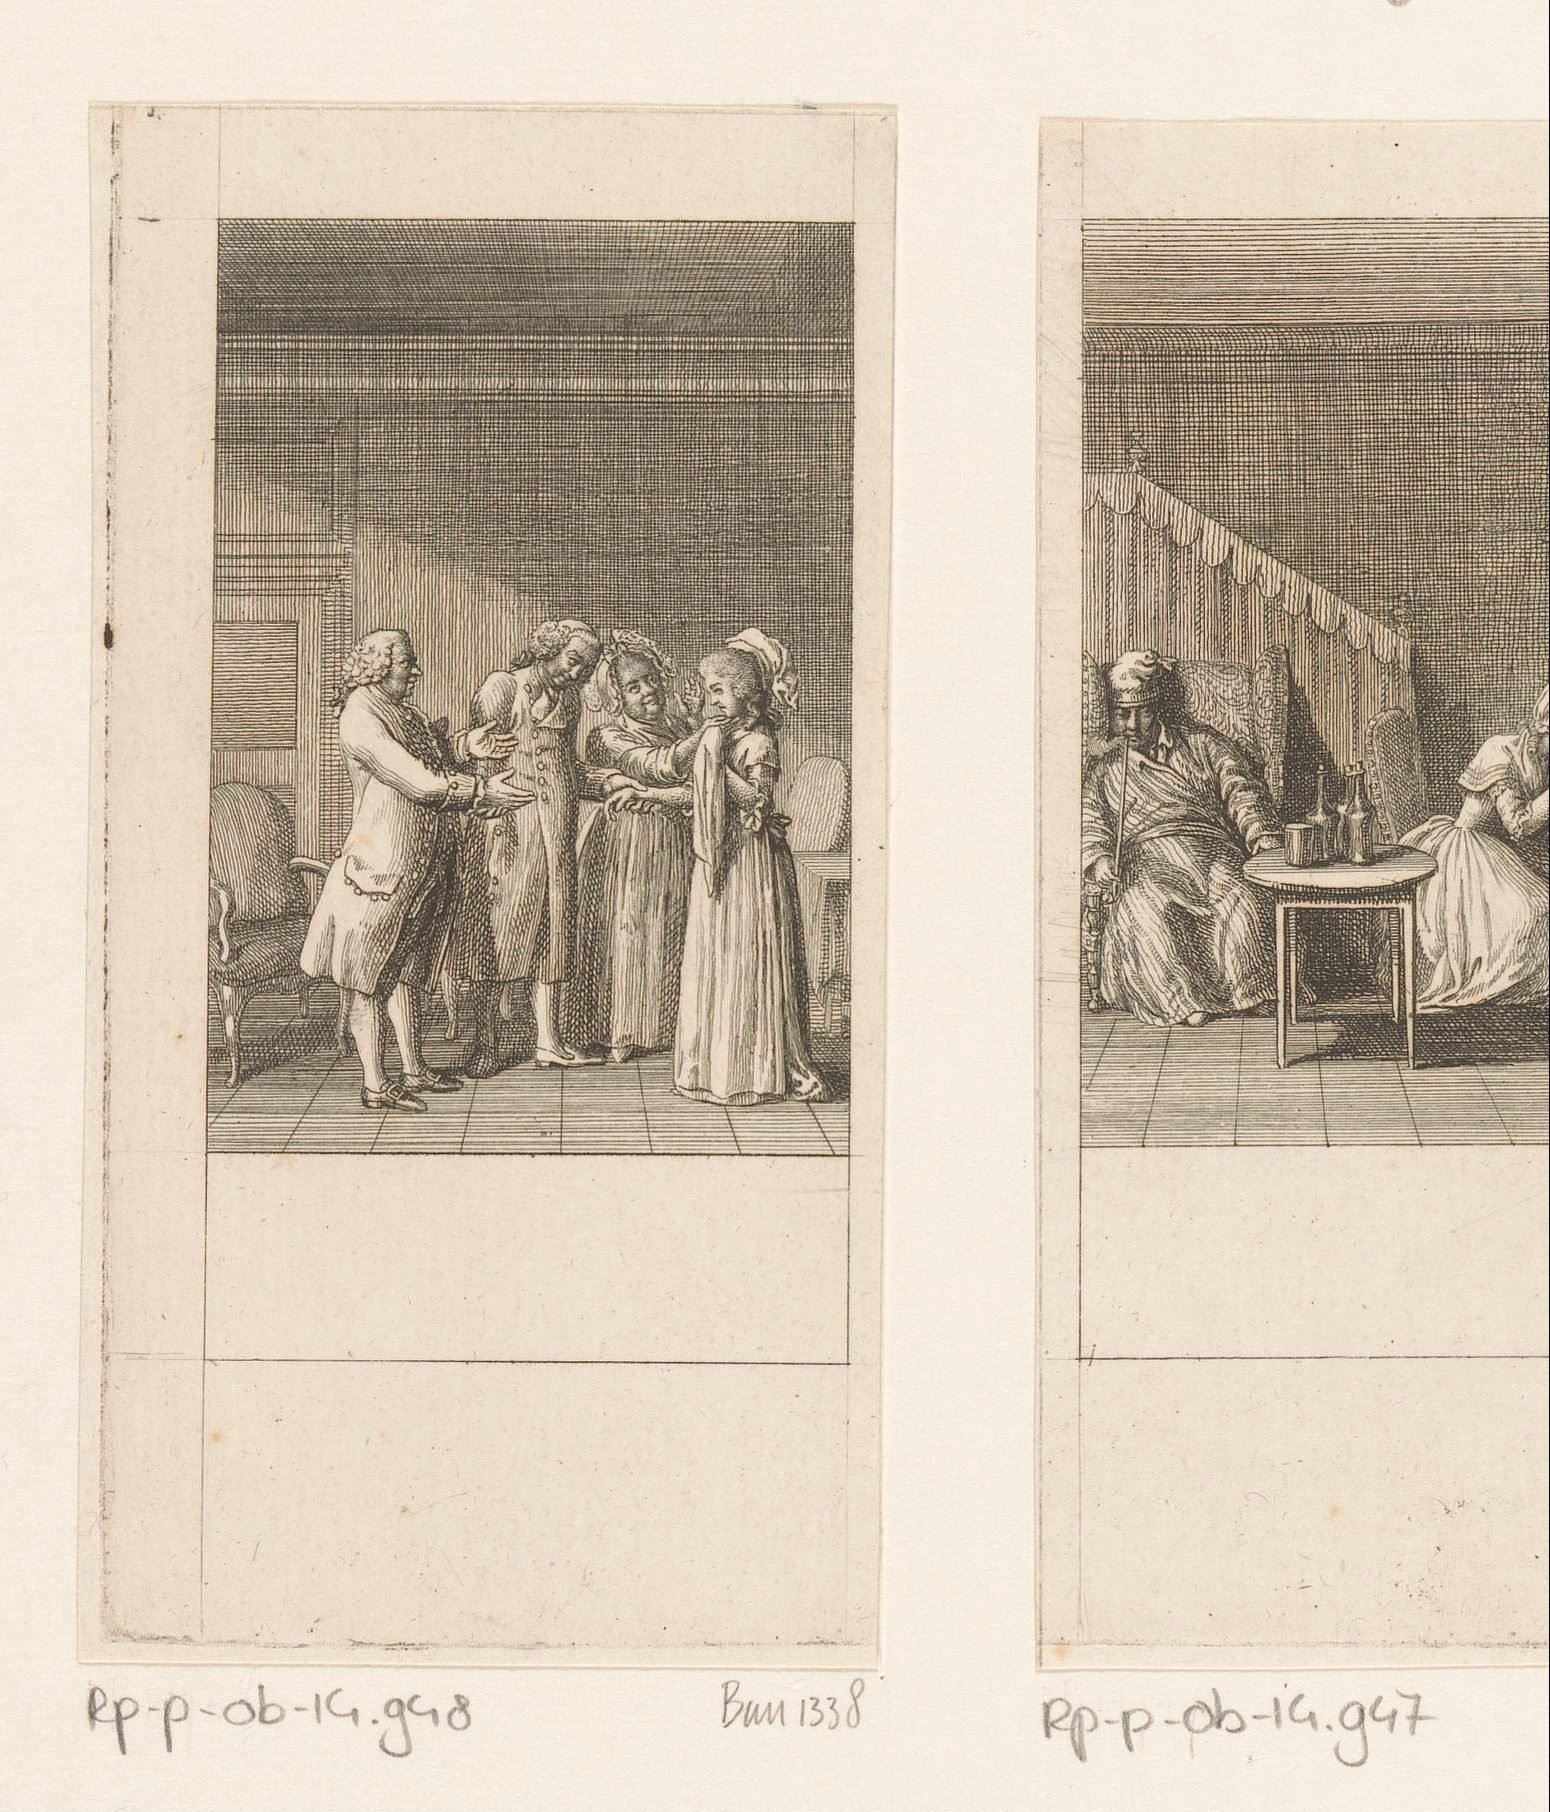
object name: print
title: Huwelijk door overtuiging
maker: daniel nikolaus chodowiecki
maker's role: draughtsman, print maker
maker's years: 1726-1801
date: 1788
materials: paper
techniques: etching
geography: berlin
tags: betrothal and marriage, persuasion; 'persuasione' (ripa)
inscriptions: collector's mark: Lugt 2228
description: Latere staat gebruikt voor: Goettinger Taschen Calender vom Jahr 1789. [Göttingen]: Johann Christoph Dietrich, [1788].